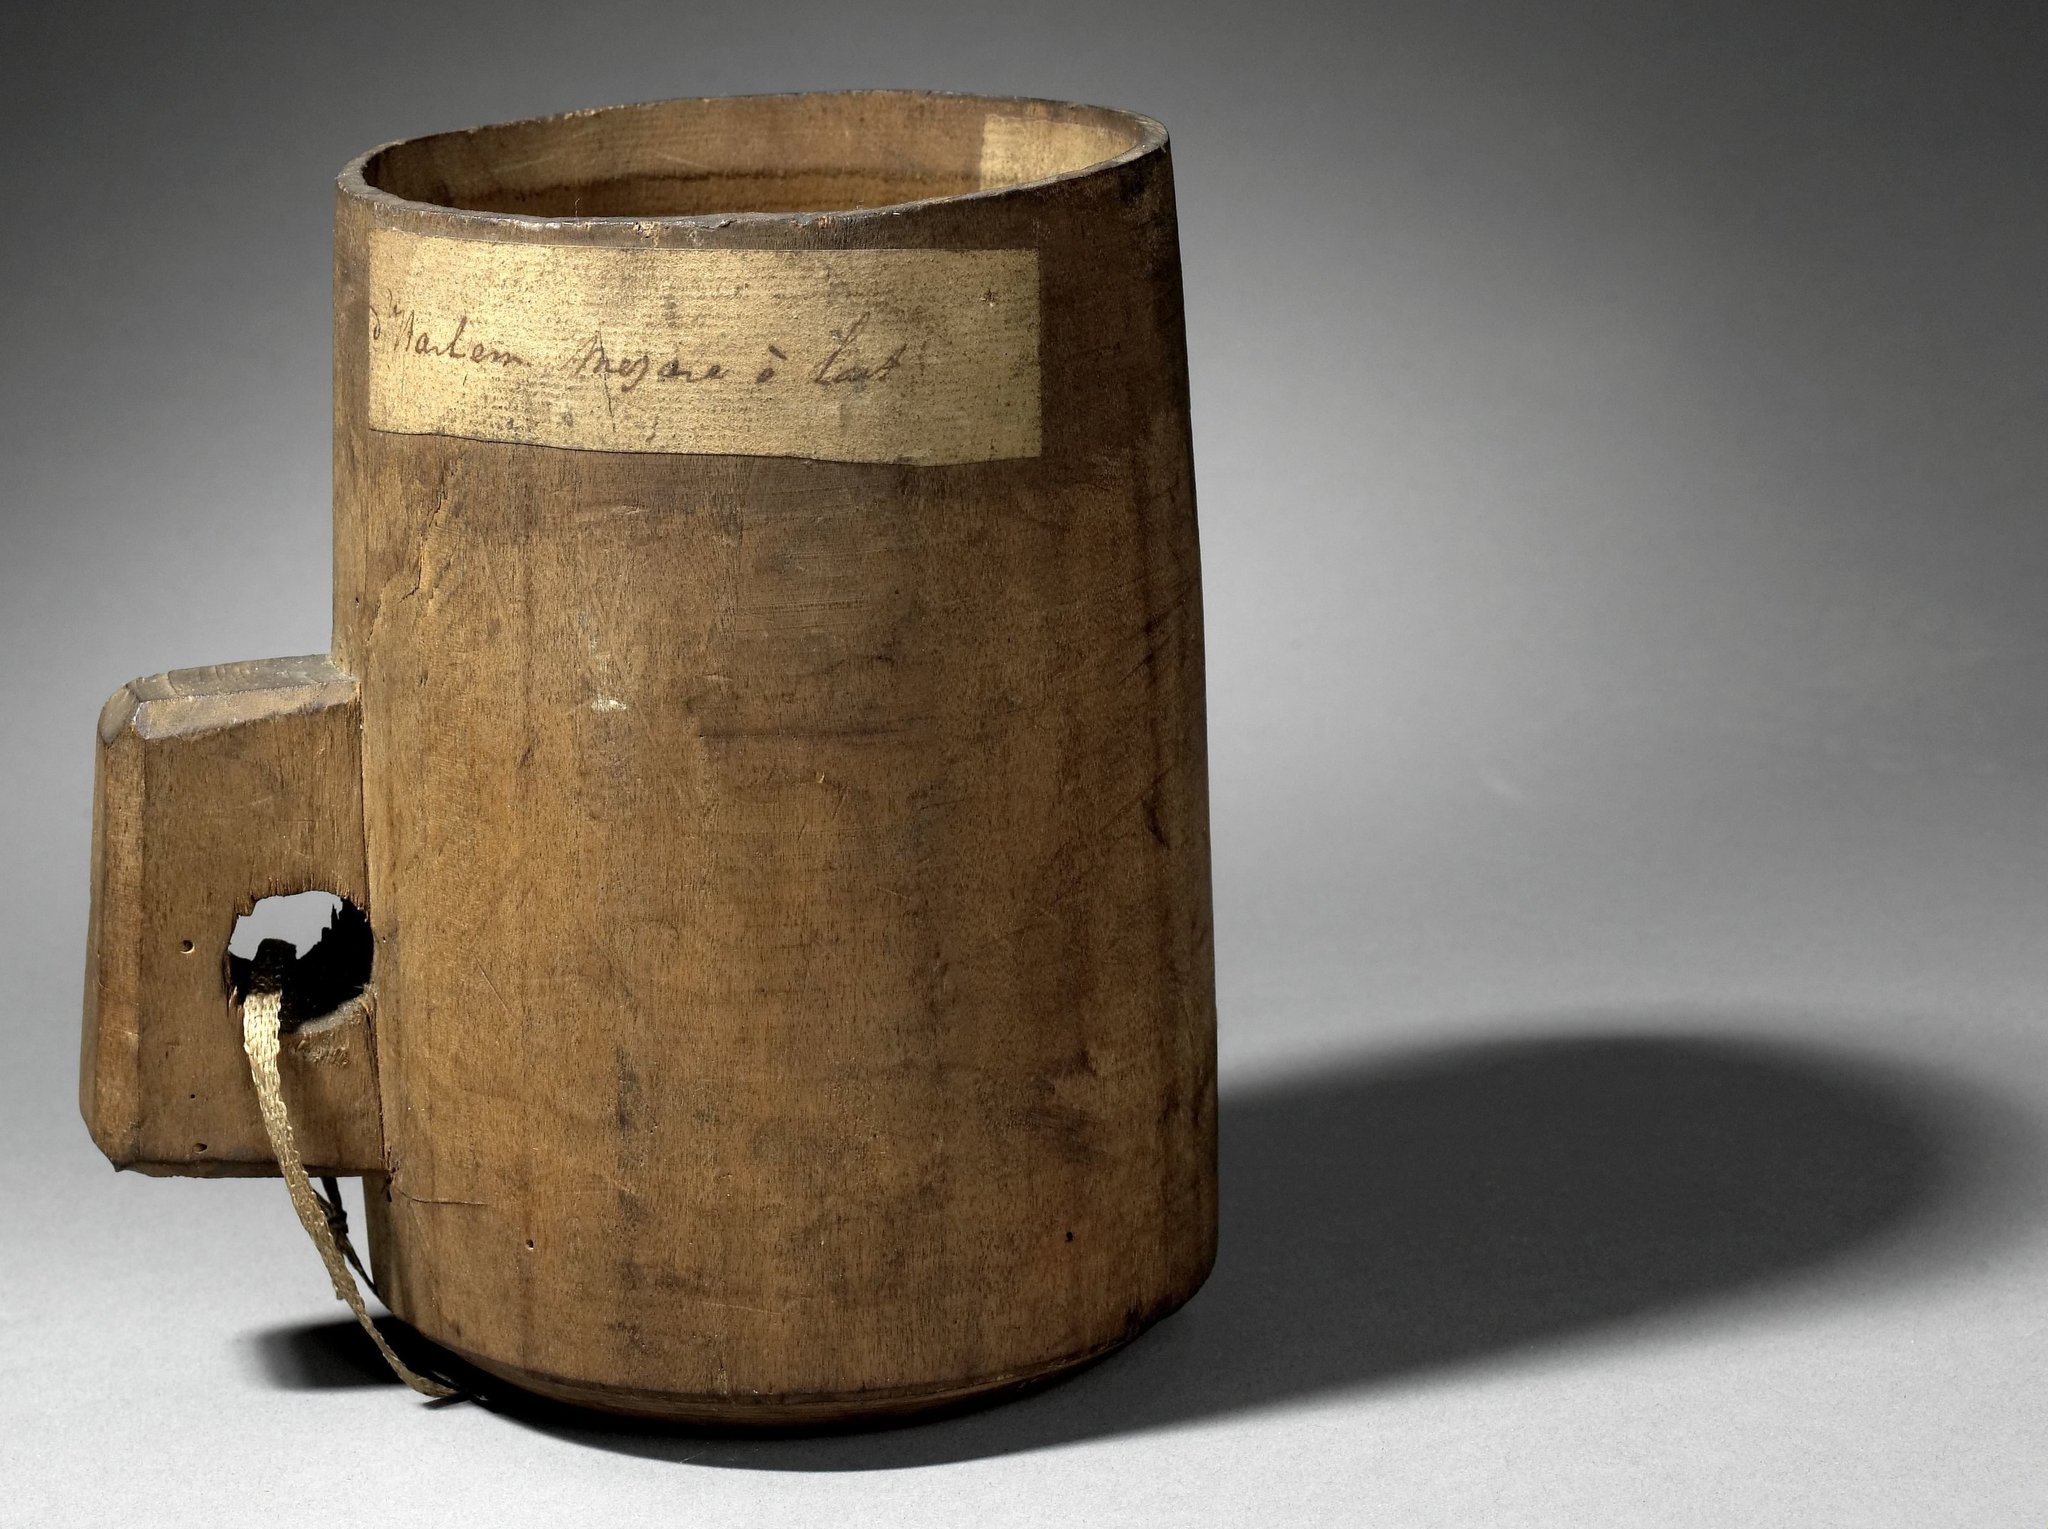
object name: melkmaat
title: Een zoete melkspintje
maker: Anonymous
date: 1800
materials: wood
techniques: turning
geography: haarlem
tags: haarlem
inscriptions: title: ‘d'Harlem, mesure à lait / 58’, title: ‘Haarlem / Een zoete melkspintje’, inscription: ‘58’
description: Melkmaat van 1 pint met oor. Gemerkt, getiteld, gelabeld en v.z.v. etiket.